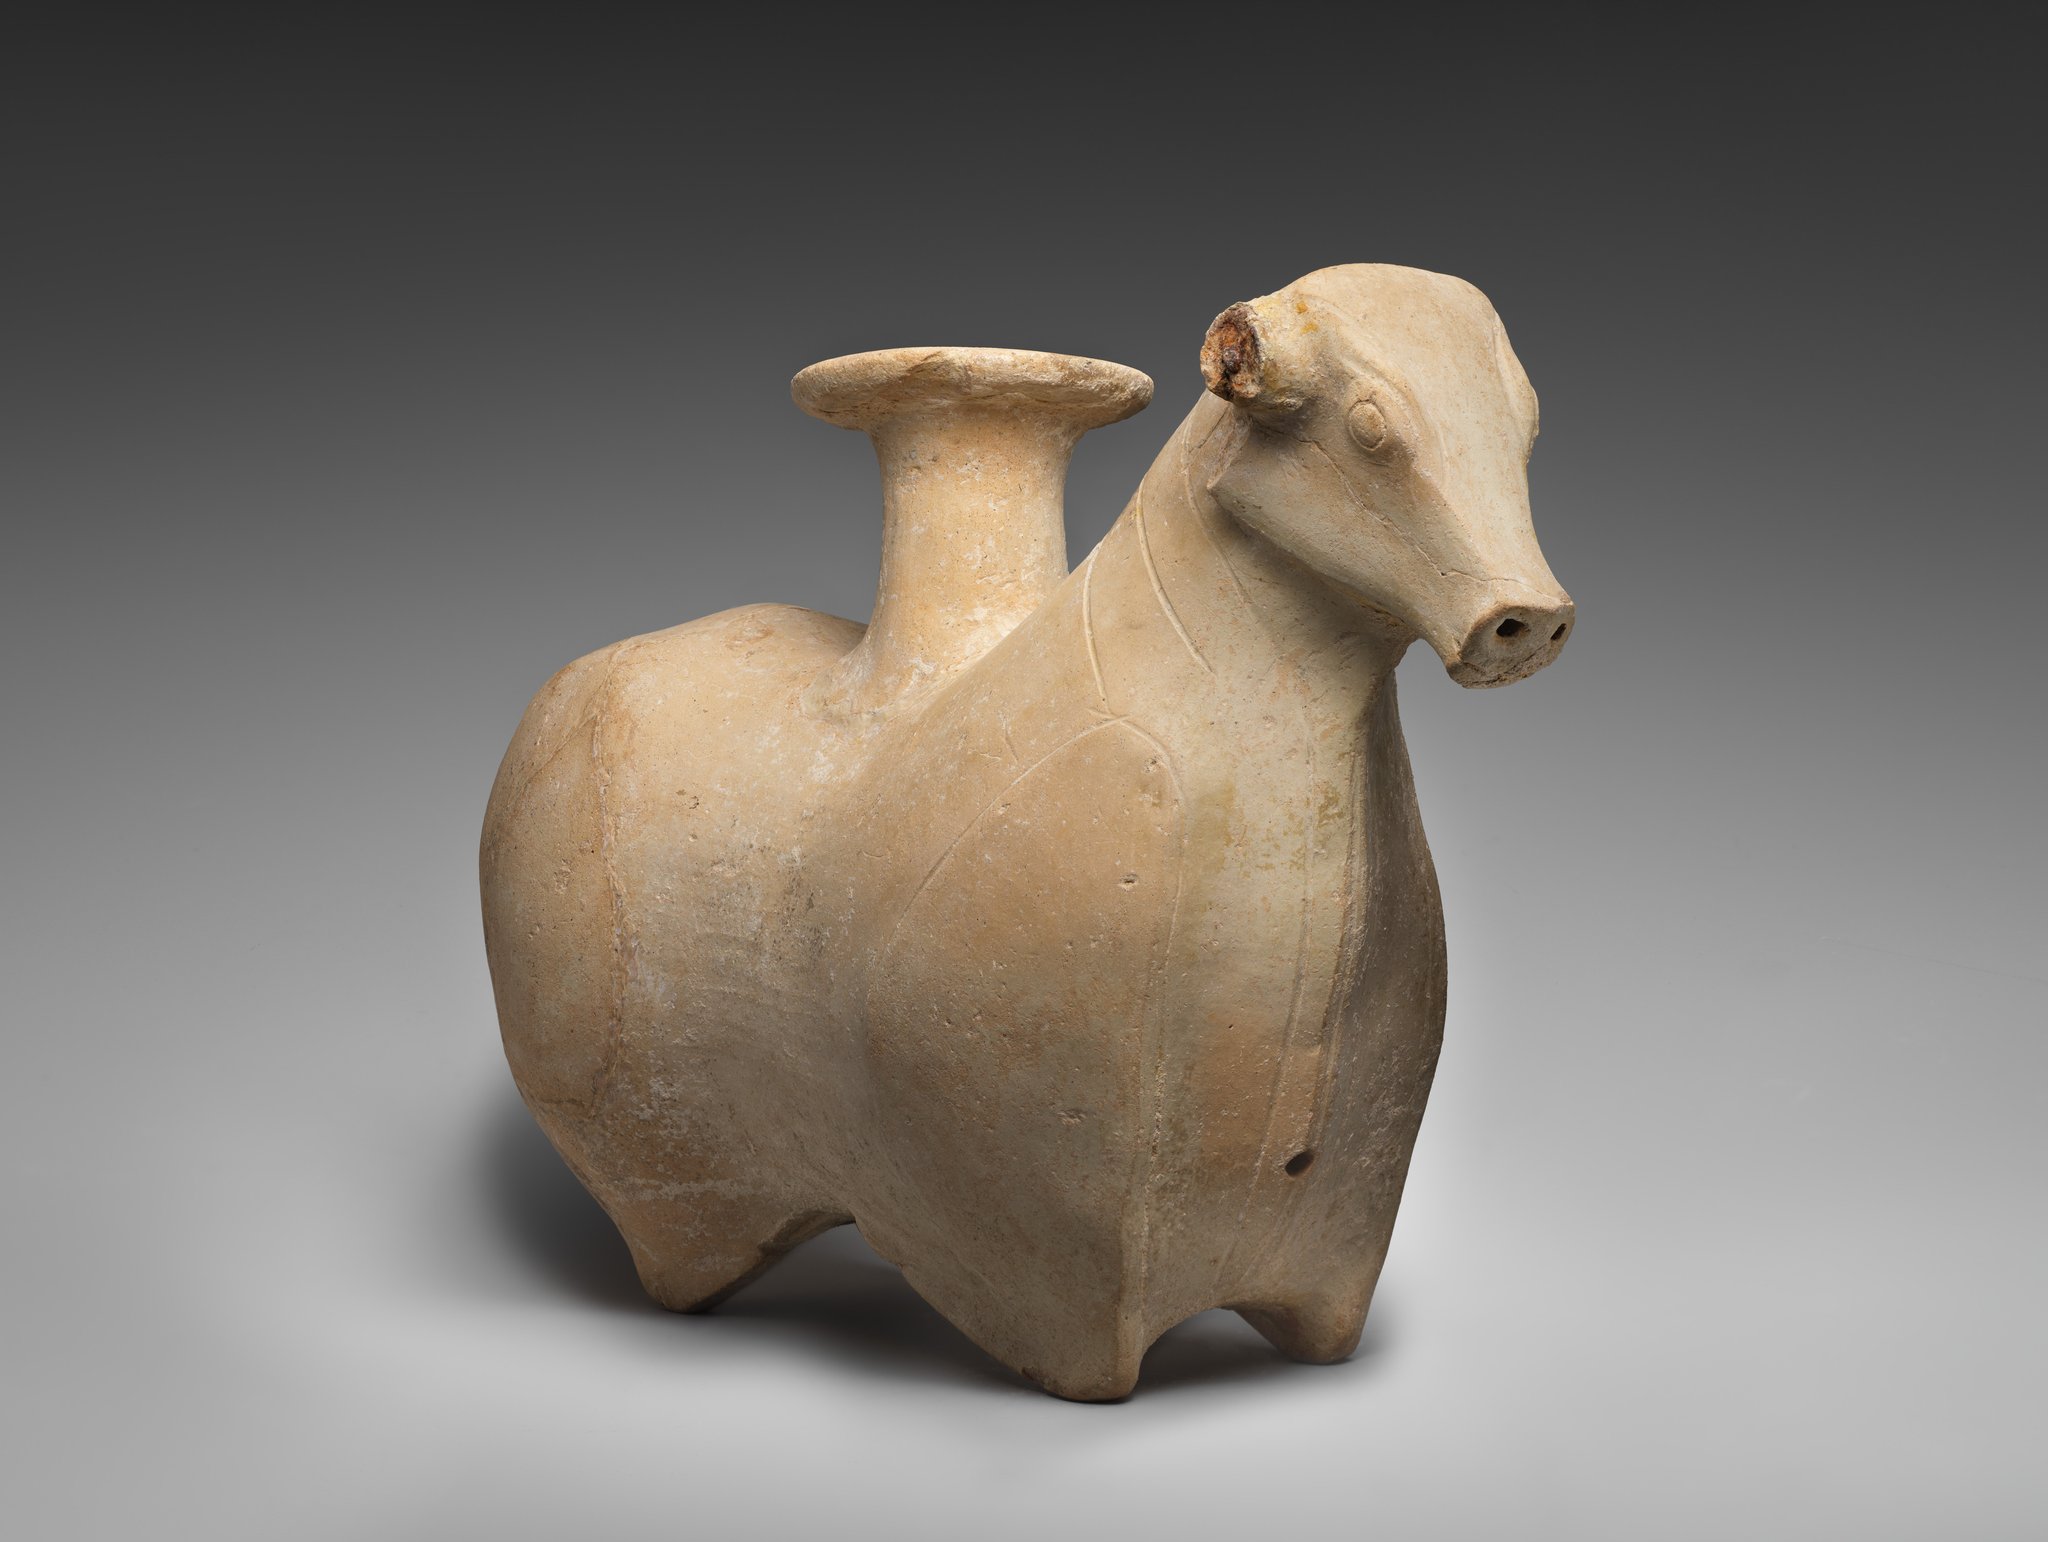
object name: vessel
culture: parthian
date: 668-1000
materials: ceramic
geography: northwestern iran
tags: animals